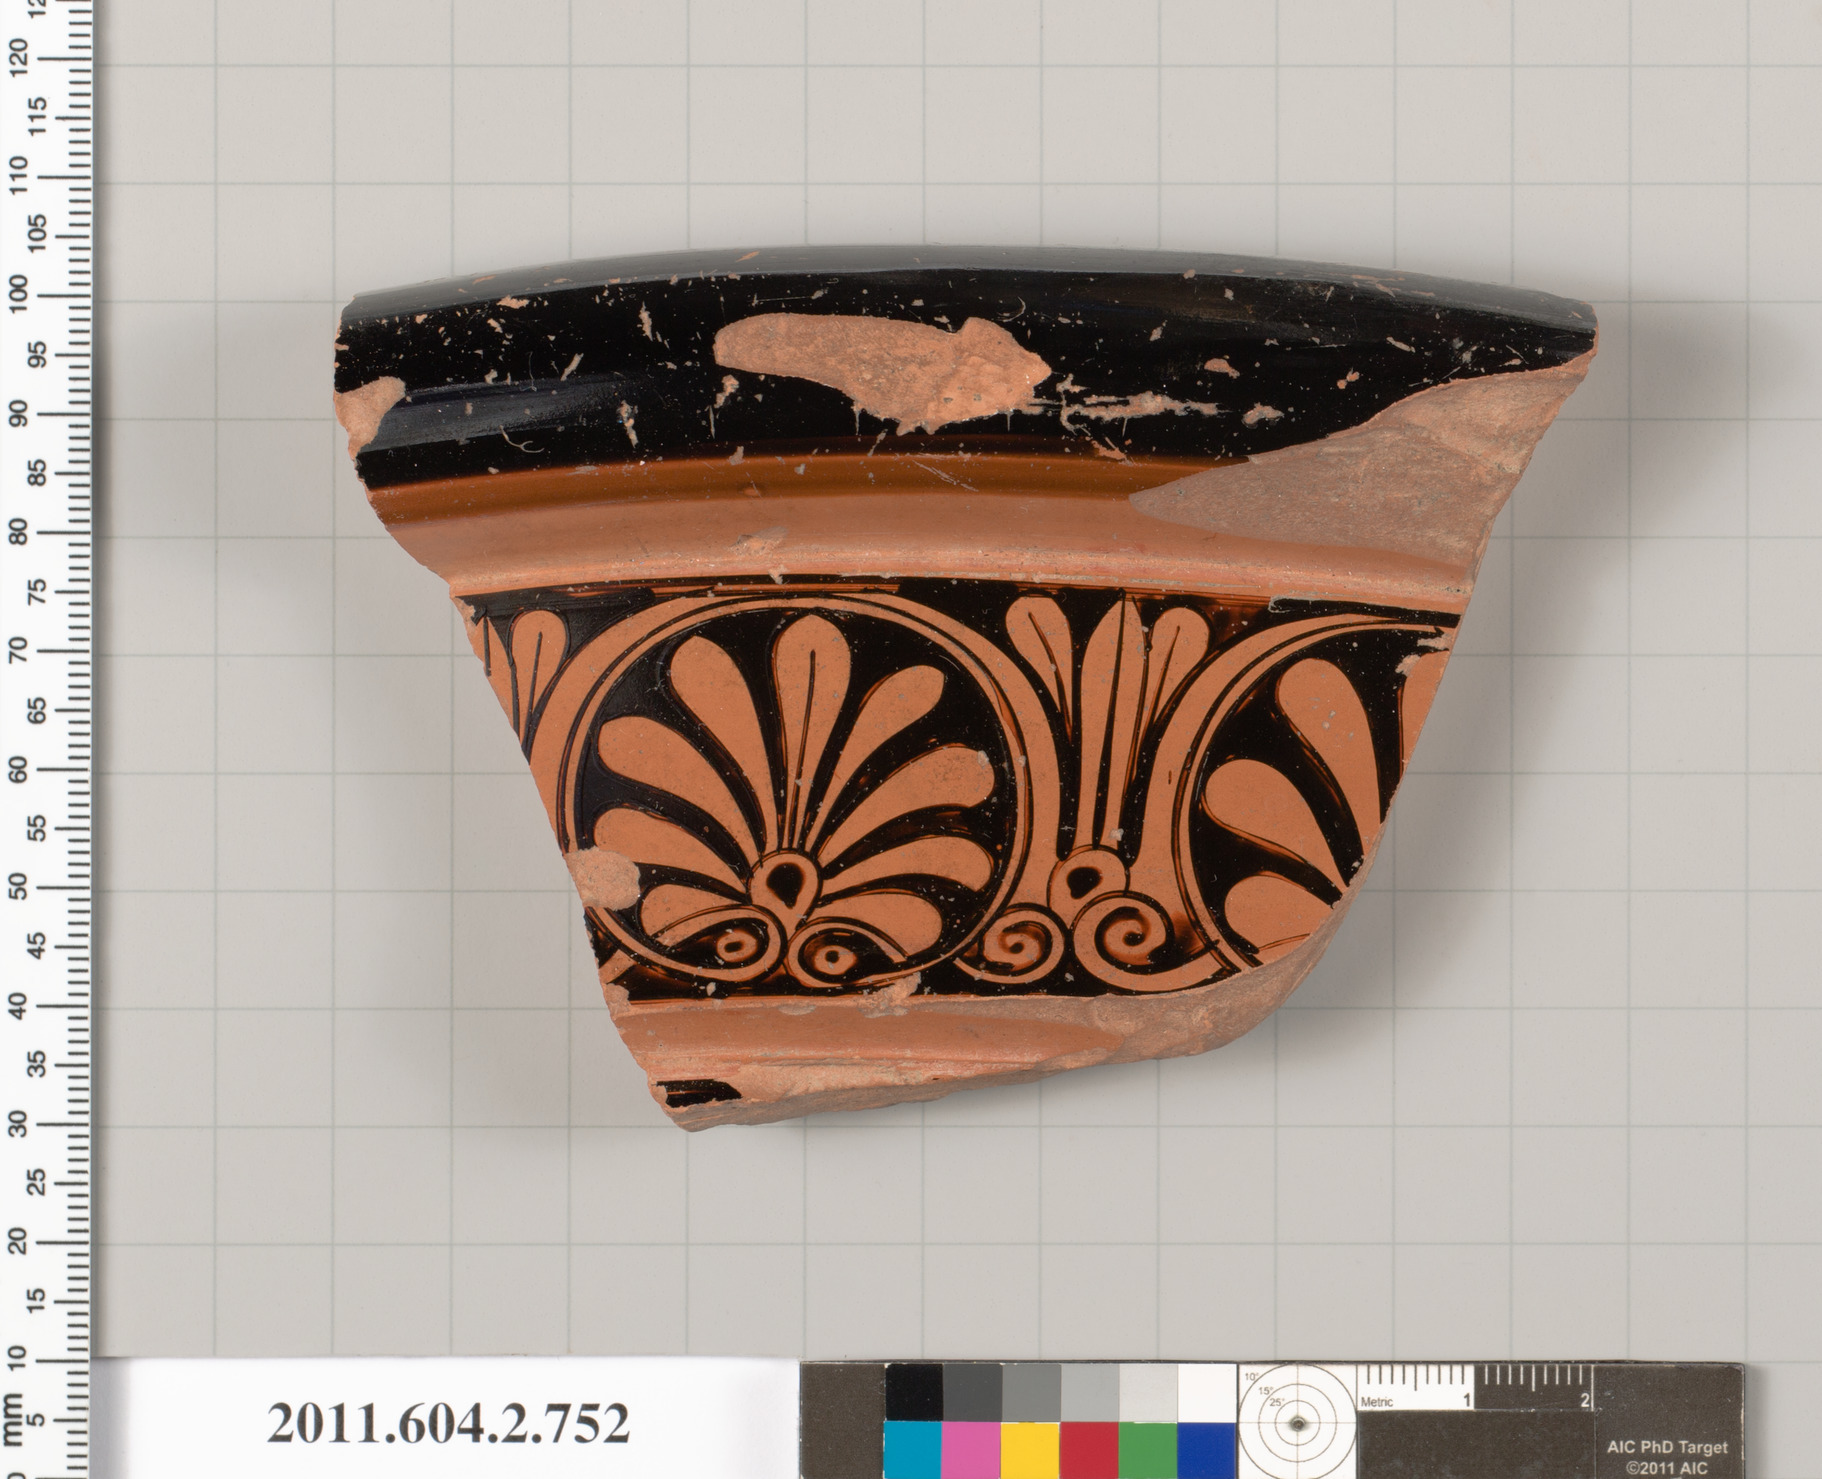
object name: calyx krater fragment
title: Terracotta fragment of a calyx-krater (bowl for mixing wine and water)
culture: greek, attic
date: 500-476 BCE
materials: terracotta